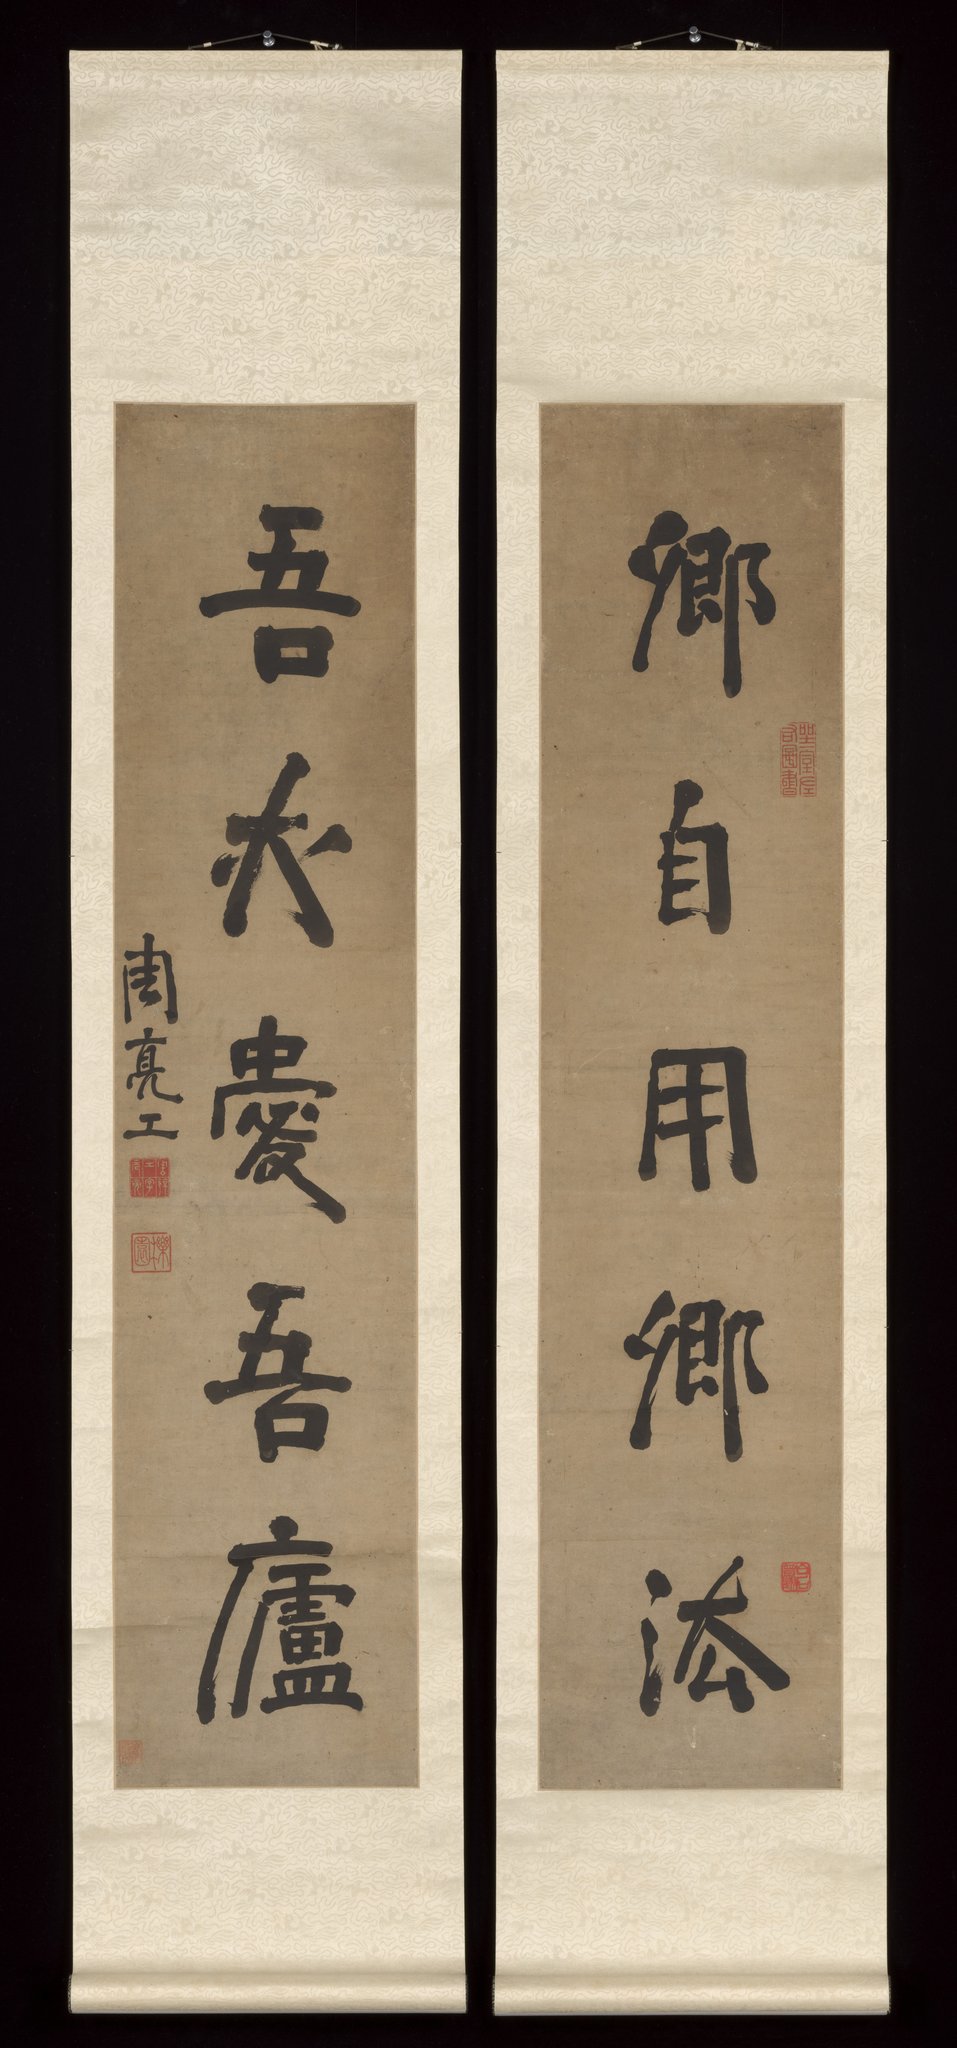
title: Couplet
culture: chinese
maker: zhou lianggong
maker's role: artist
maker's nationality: chinese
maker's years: 1612-1672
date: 1634-1666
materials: ink, paper